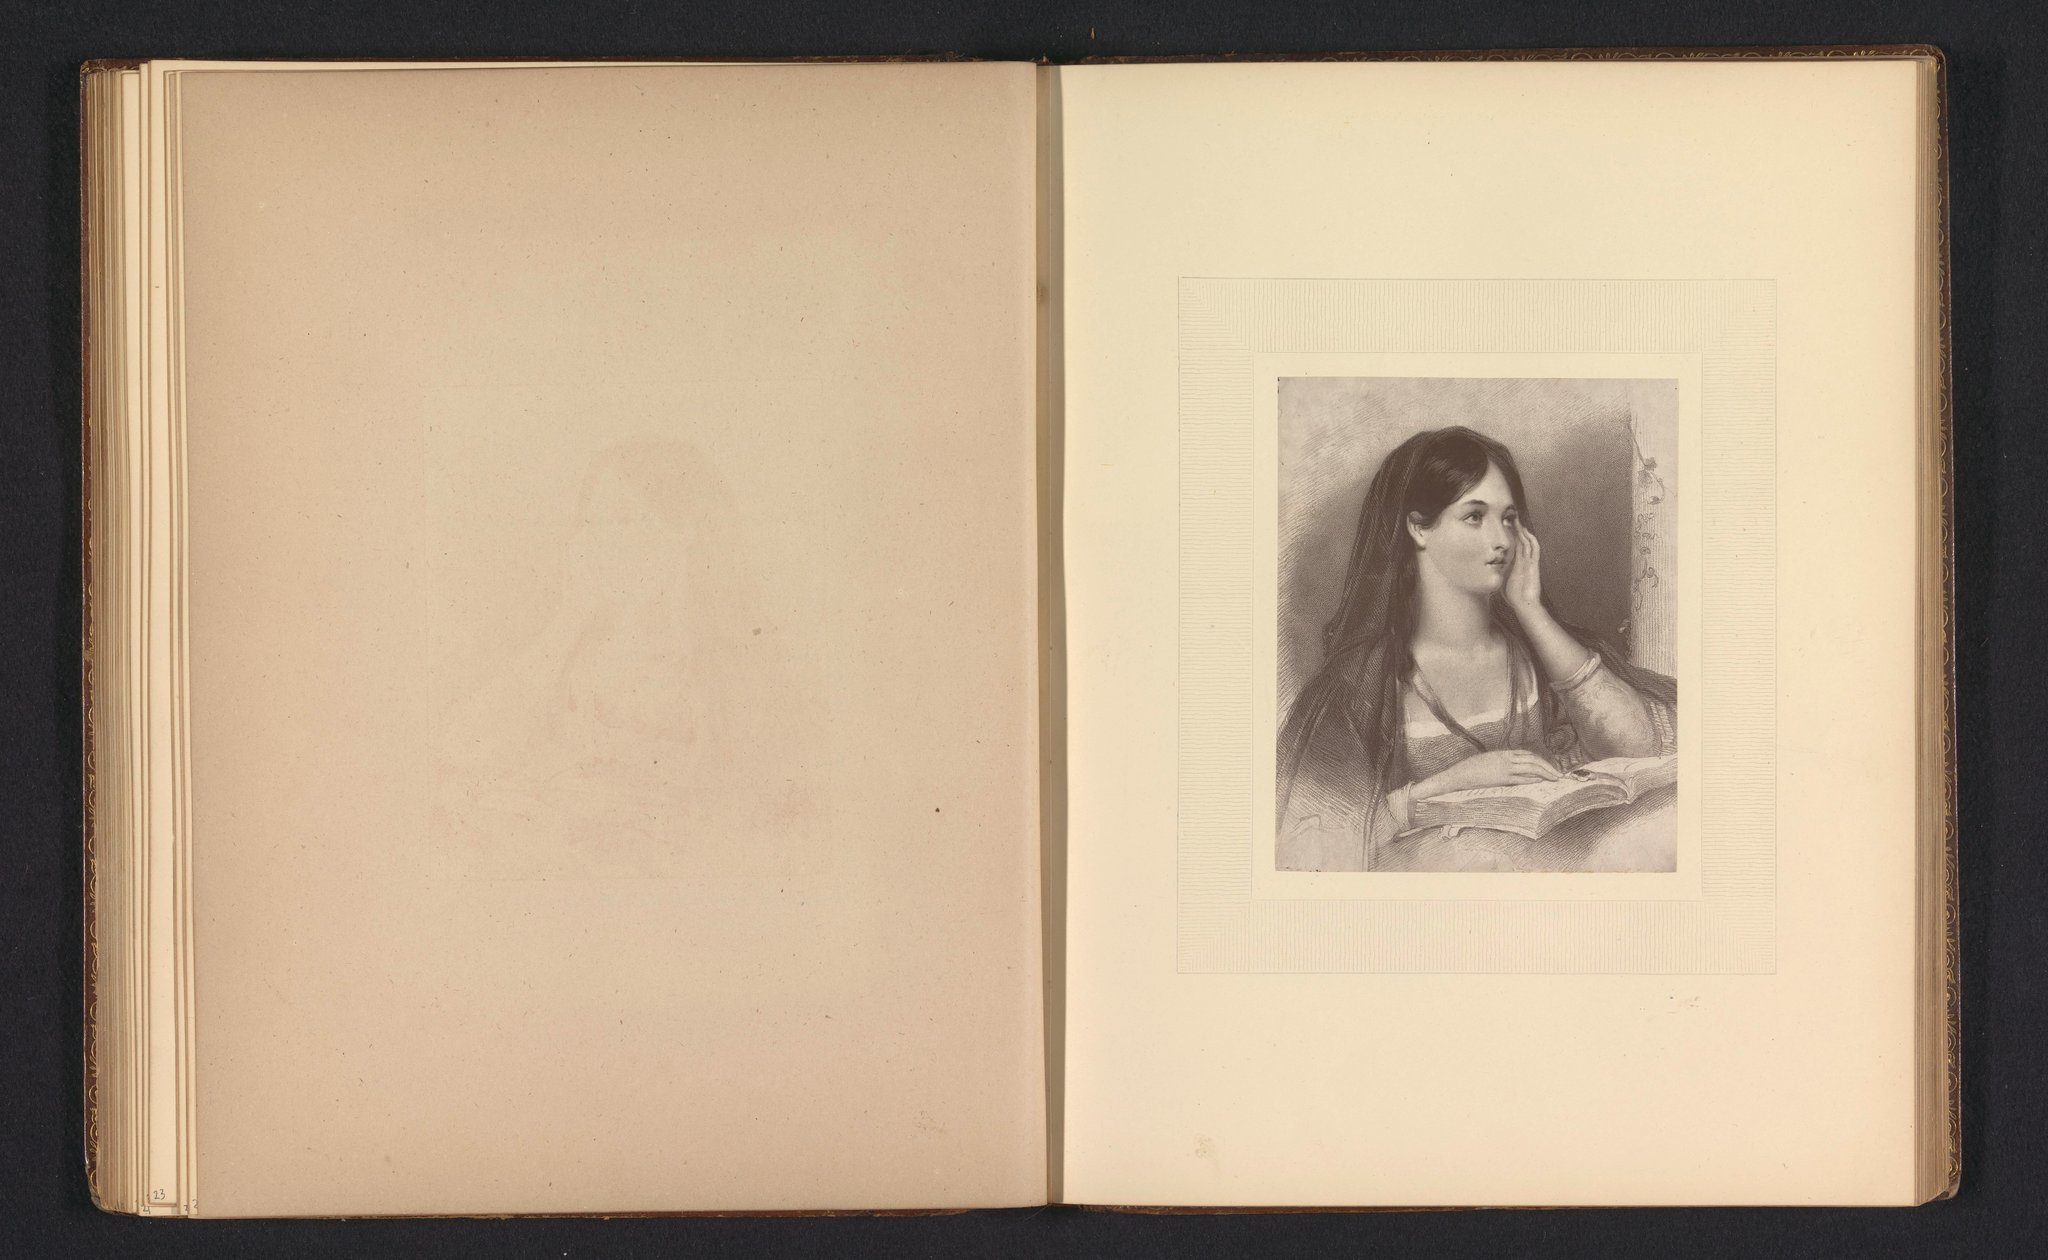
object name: reproduction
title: Fotoreproductie van een prent naar een schilderij van een vrouw met een boek door William Boxall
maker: Anonymous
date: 1864-1874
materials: paper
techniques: woodburytype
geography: london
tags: picture, painting